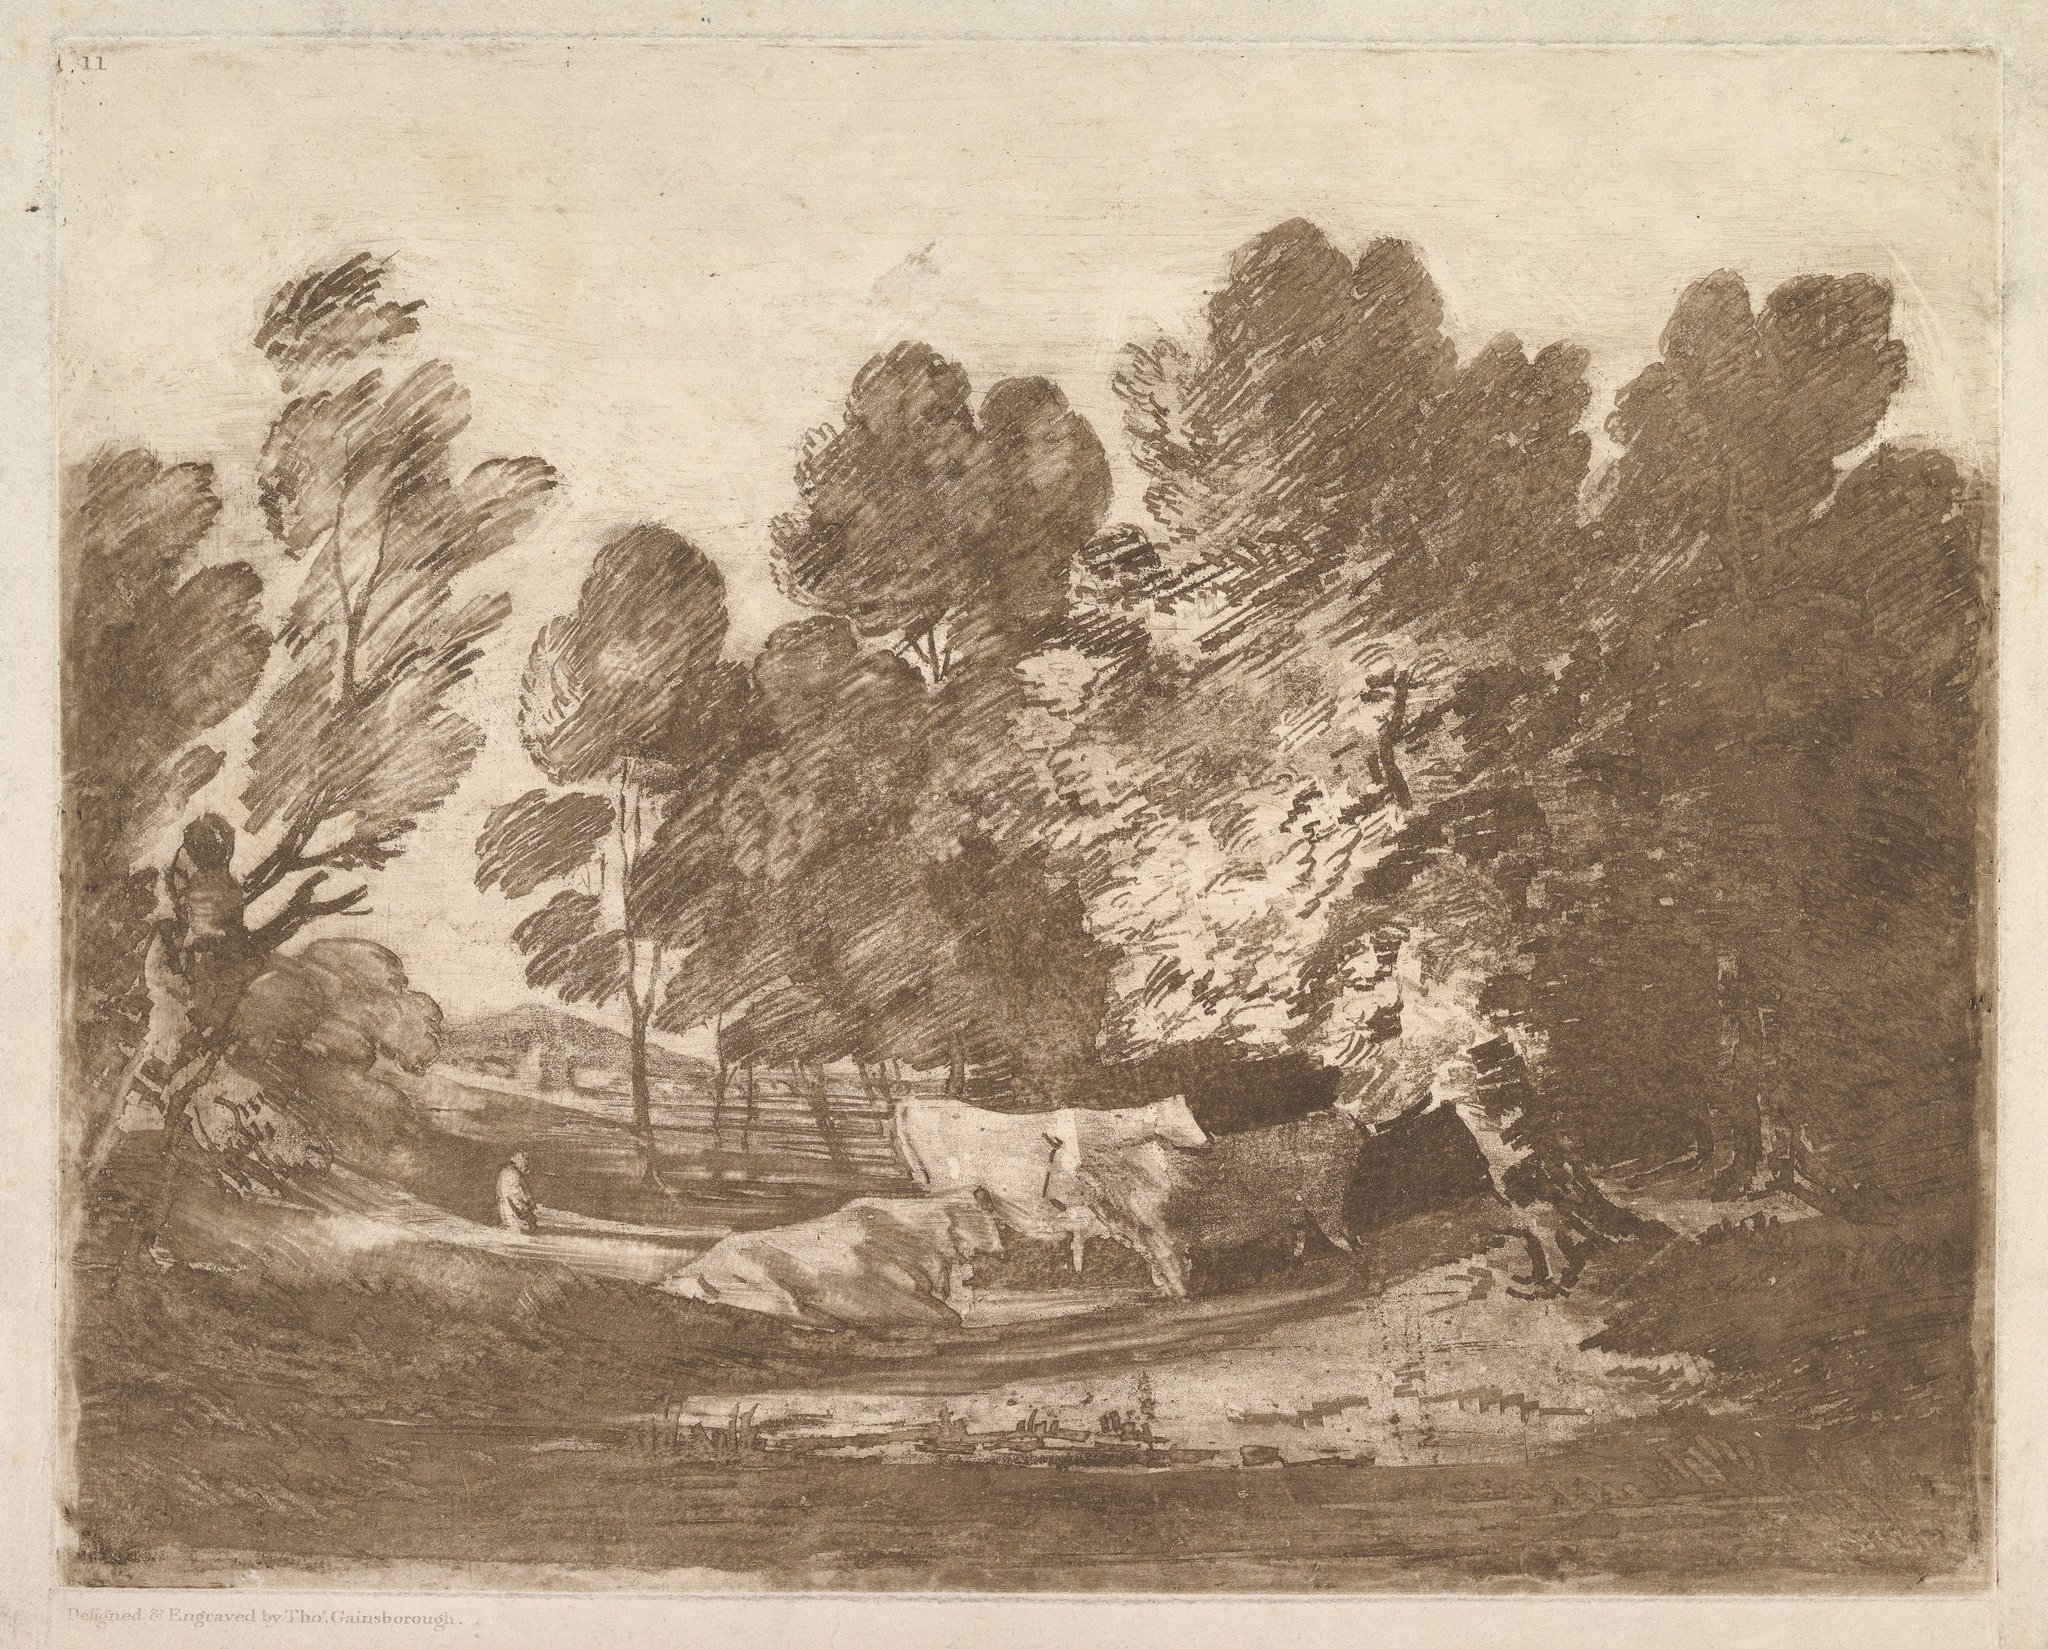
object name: print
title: Wooded Landscape with Herdsmen and Cows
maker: thomas gainsborough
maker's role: artist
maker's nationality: british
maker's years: 1727-1788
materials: ink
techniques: aquatint, printing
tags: cows,landscapes